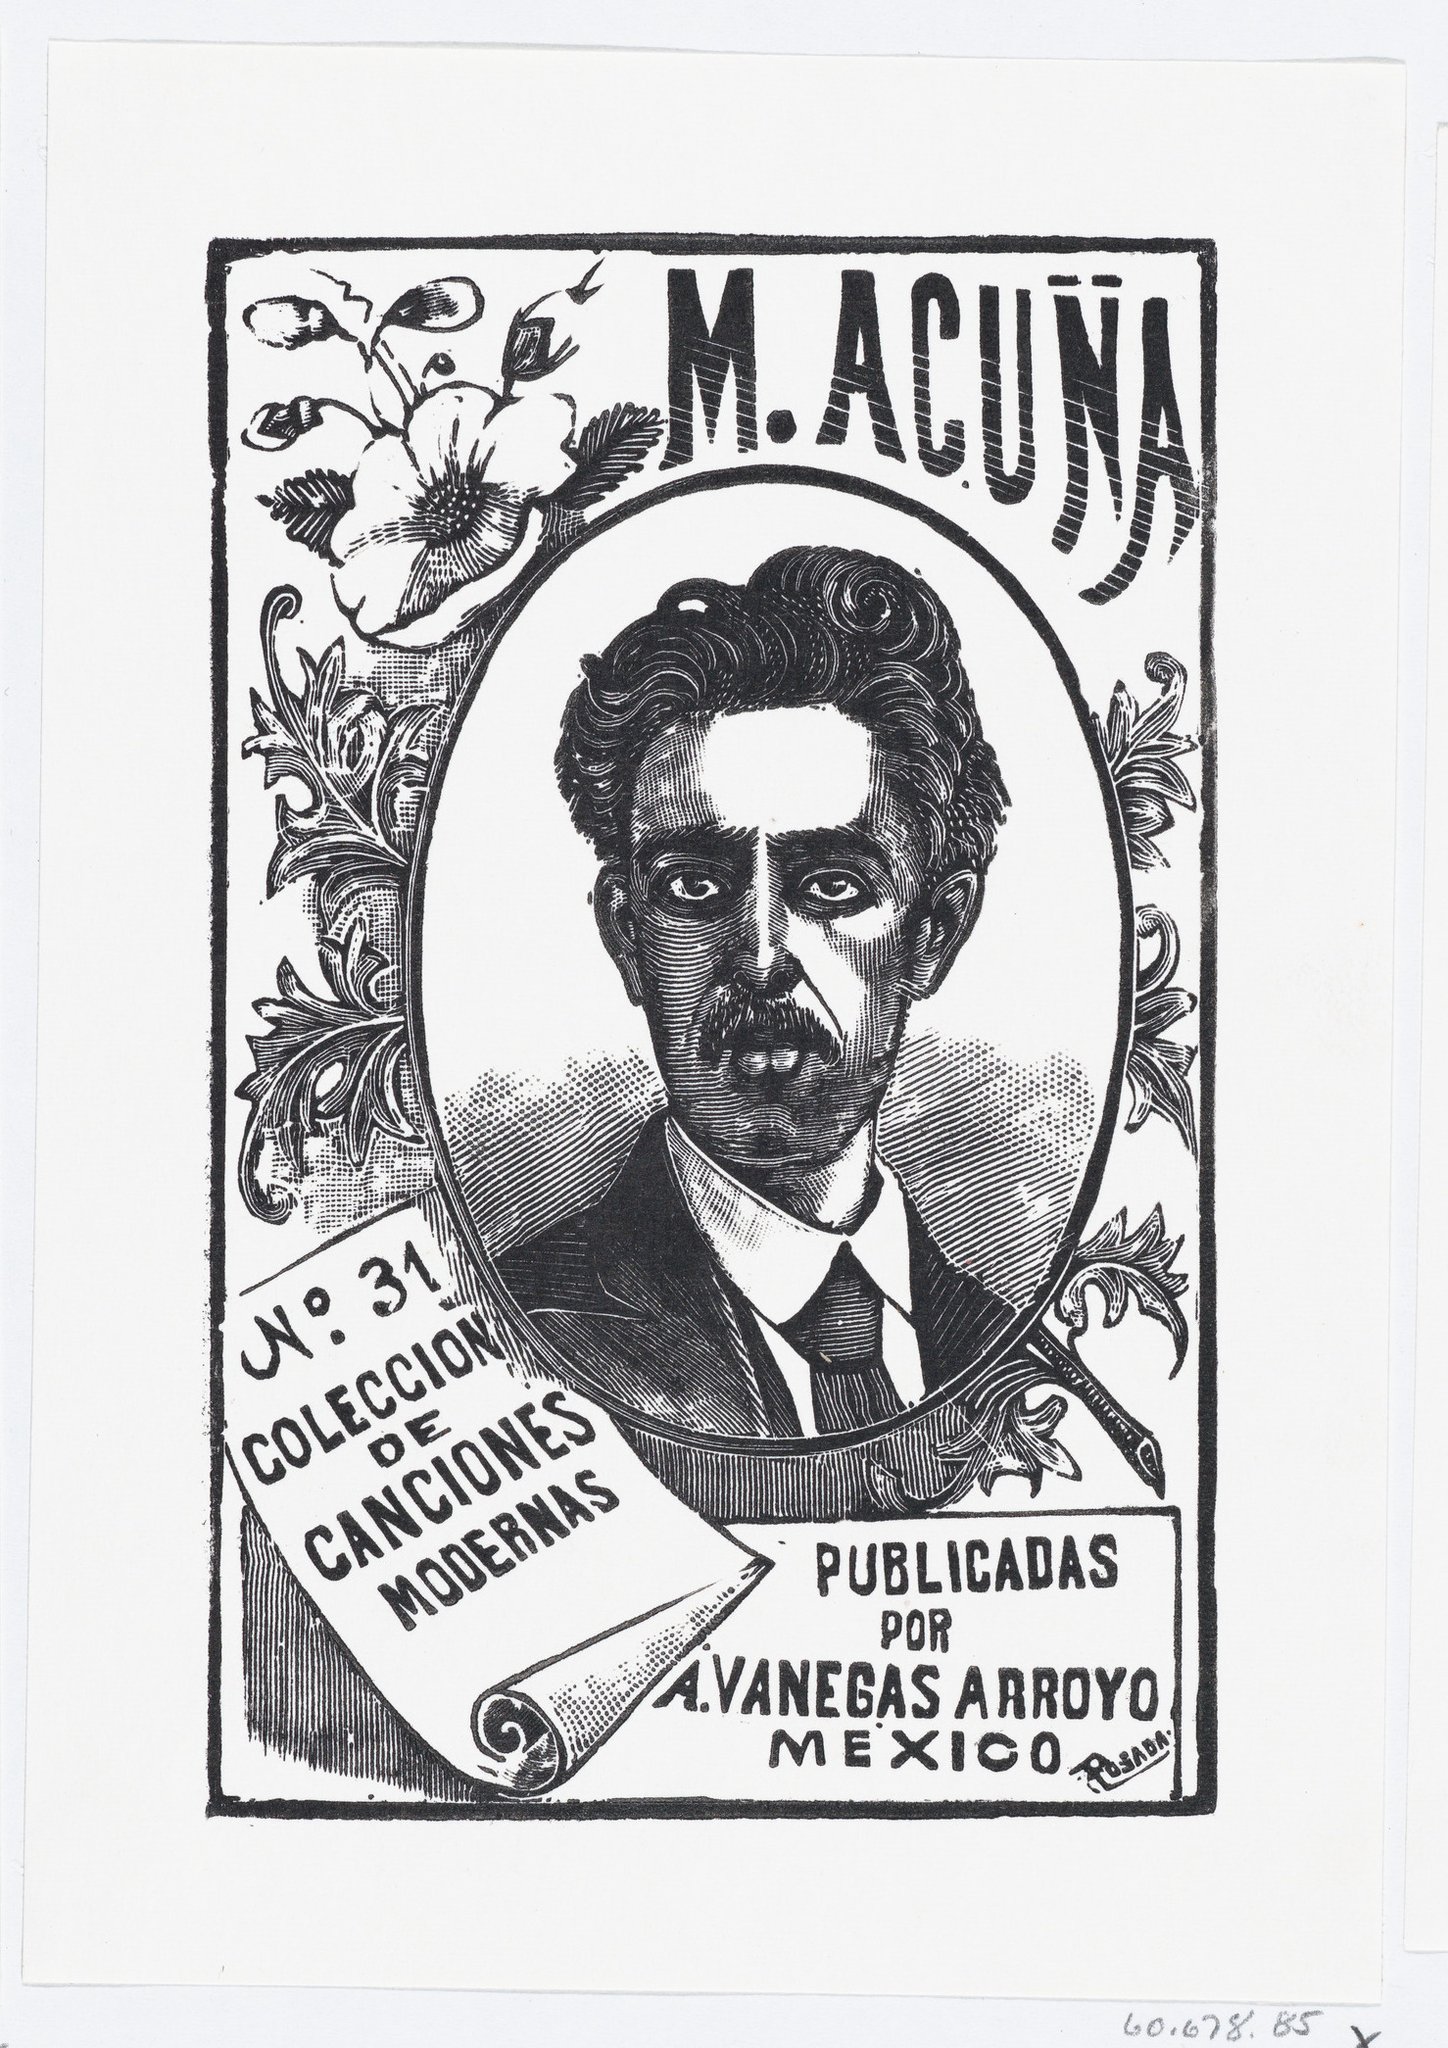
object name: print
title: A portrait of Manuel Acuña, illustration for 'Manuel Acuña'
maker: josé guadalupe posada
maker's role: artist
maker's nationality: mexican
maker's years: 1852-1913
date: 1895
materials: metal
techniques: engraving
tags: men,portraits